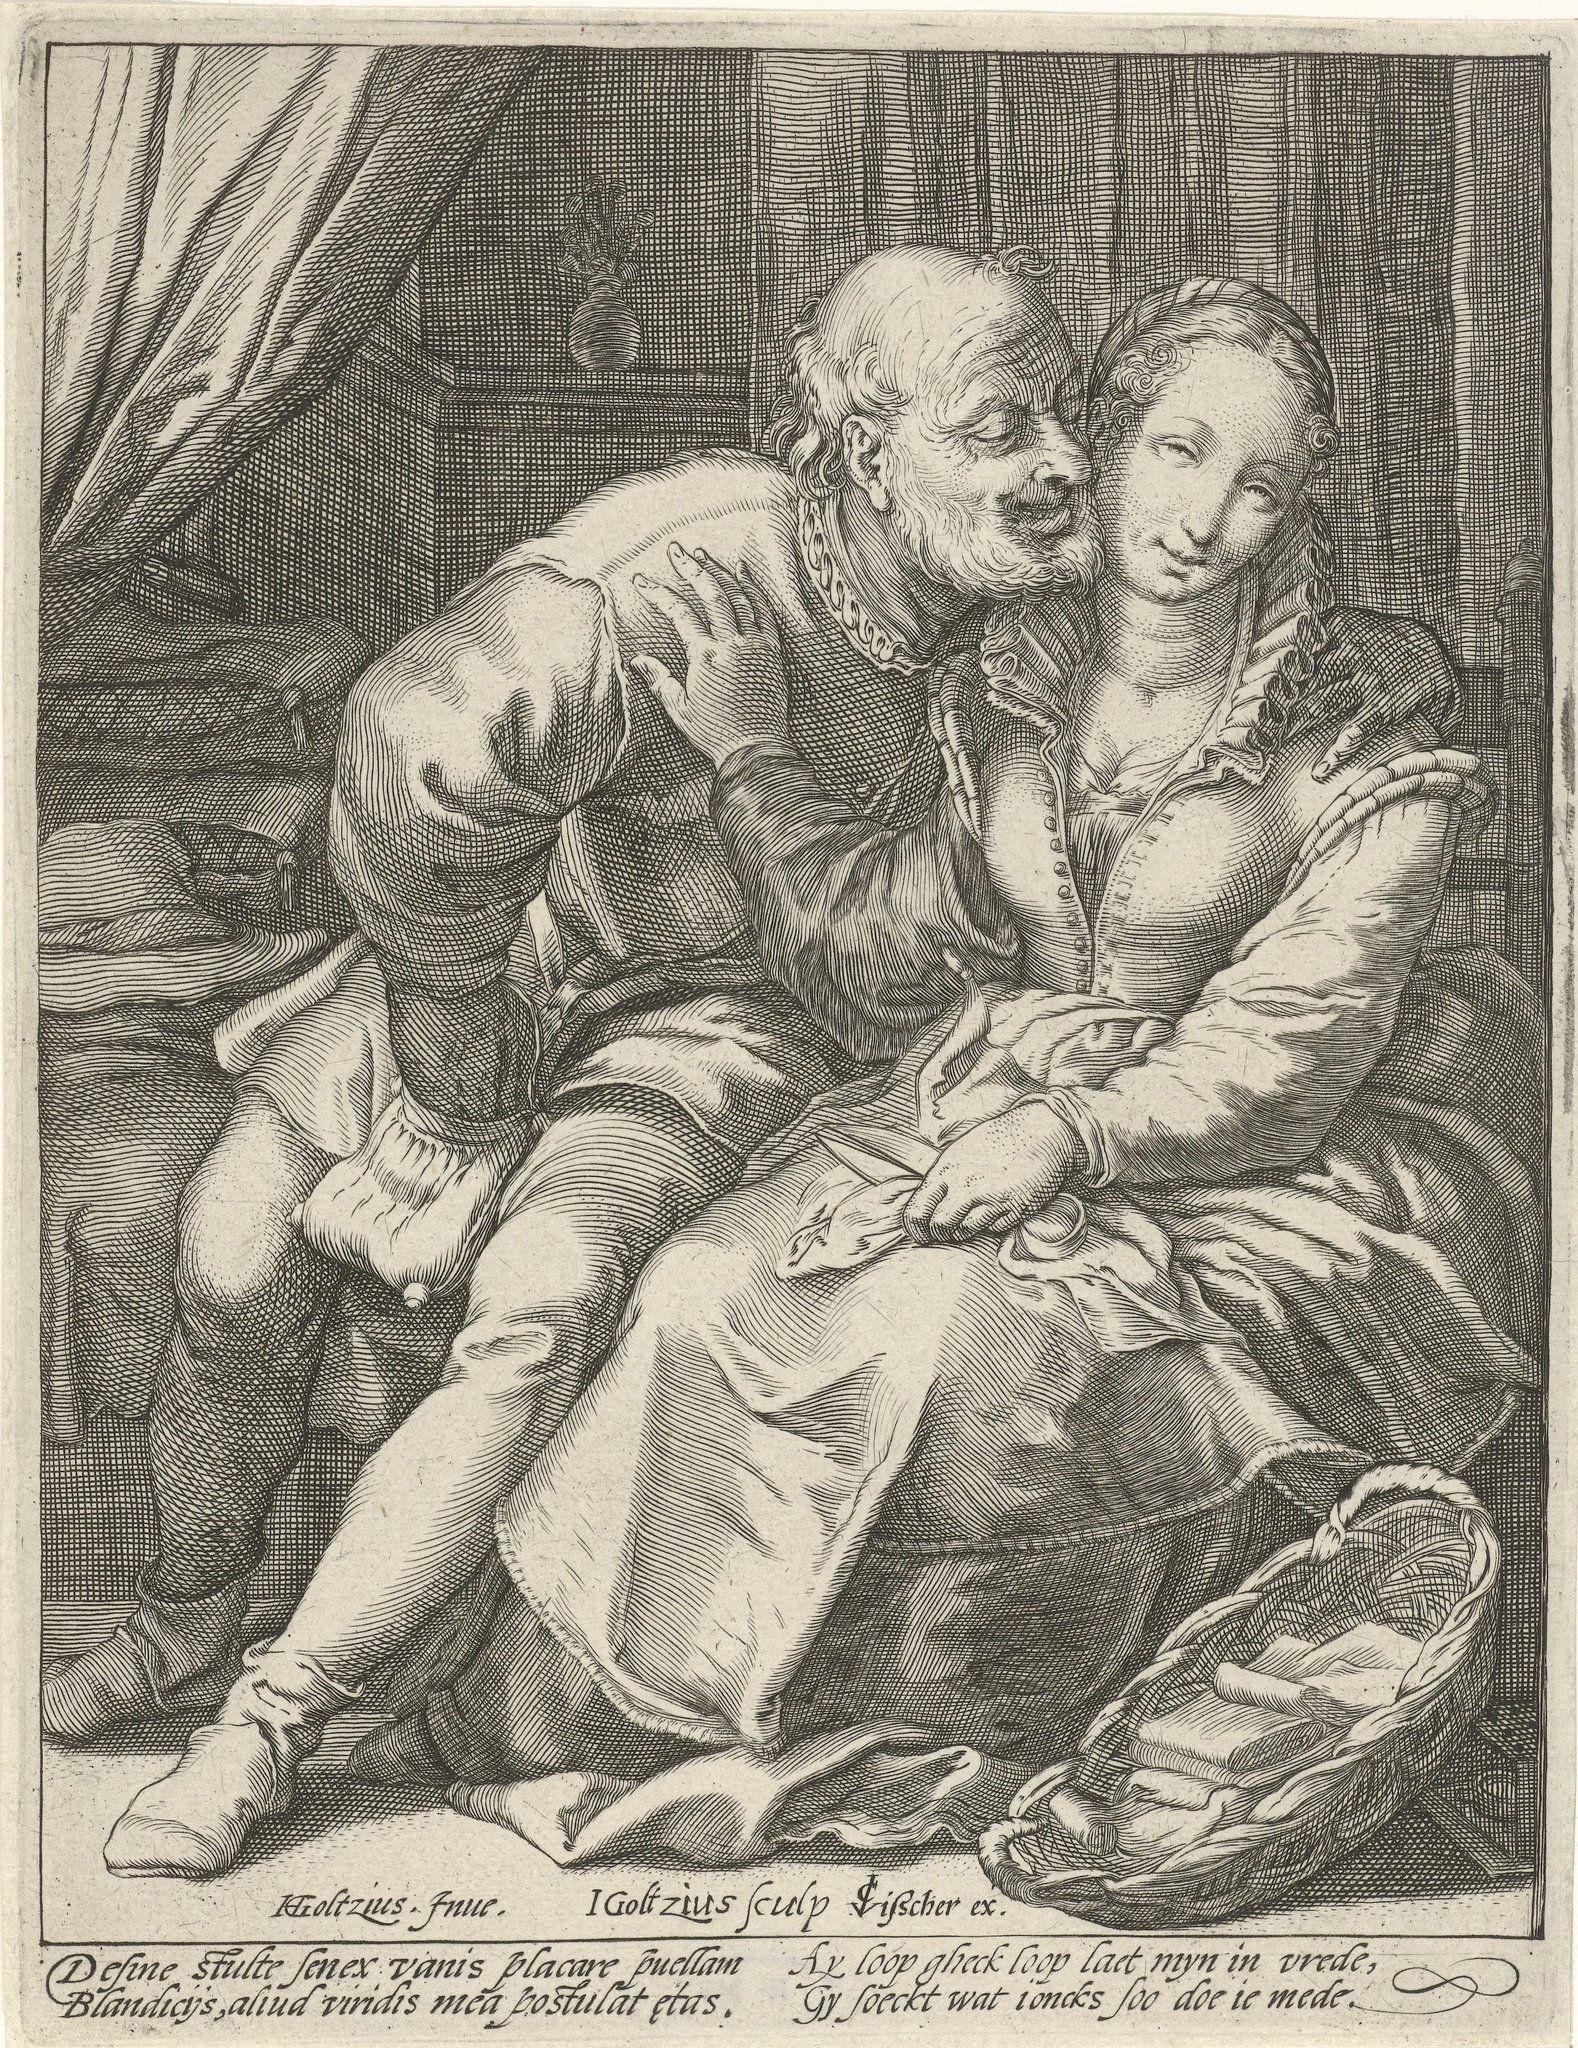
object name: print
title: Ongelijke liefde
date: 1605-1630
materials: paper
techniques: engraving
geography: amsterdam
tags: purse, money-bag, one-sided courting; pursuit; difficult choice, married couple of unequal age, young versus old age; young and old, adolescent, young woman, maiden (+ old male (human being)), ugly old man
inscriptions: collector's mark: Lugt 2228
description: Een oude man zit op een stoel en tast in zijn geldbuidel. Naast hem een jonge vrouw op een stoel. De oude man probeert de vrouw te kussen, maar zij draait zich weg van hem en houdt hem tegen. De prent heeft een Latijns en Nederlands onderschrift